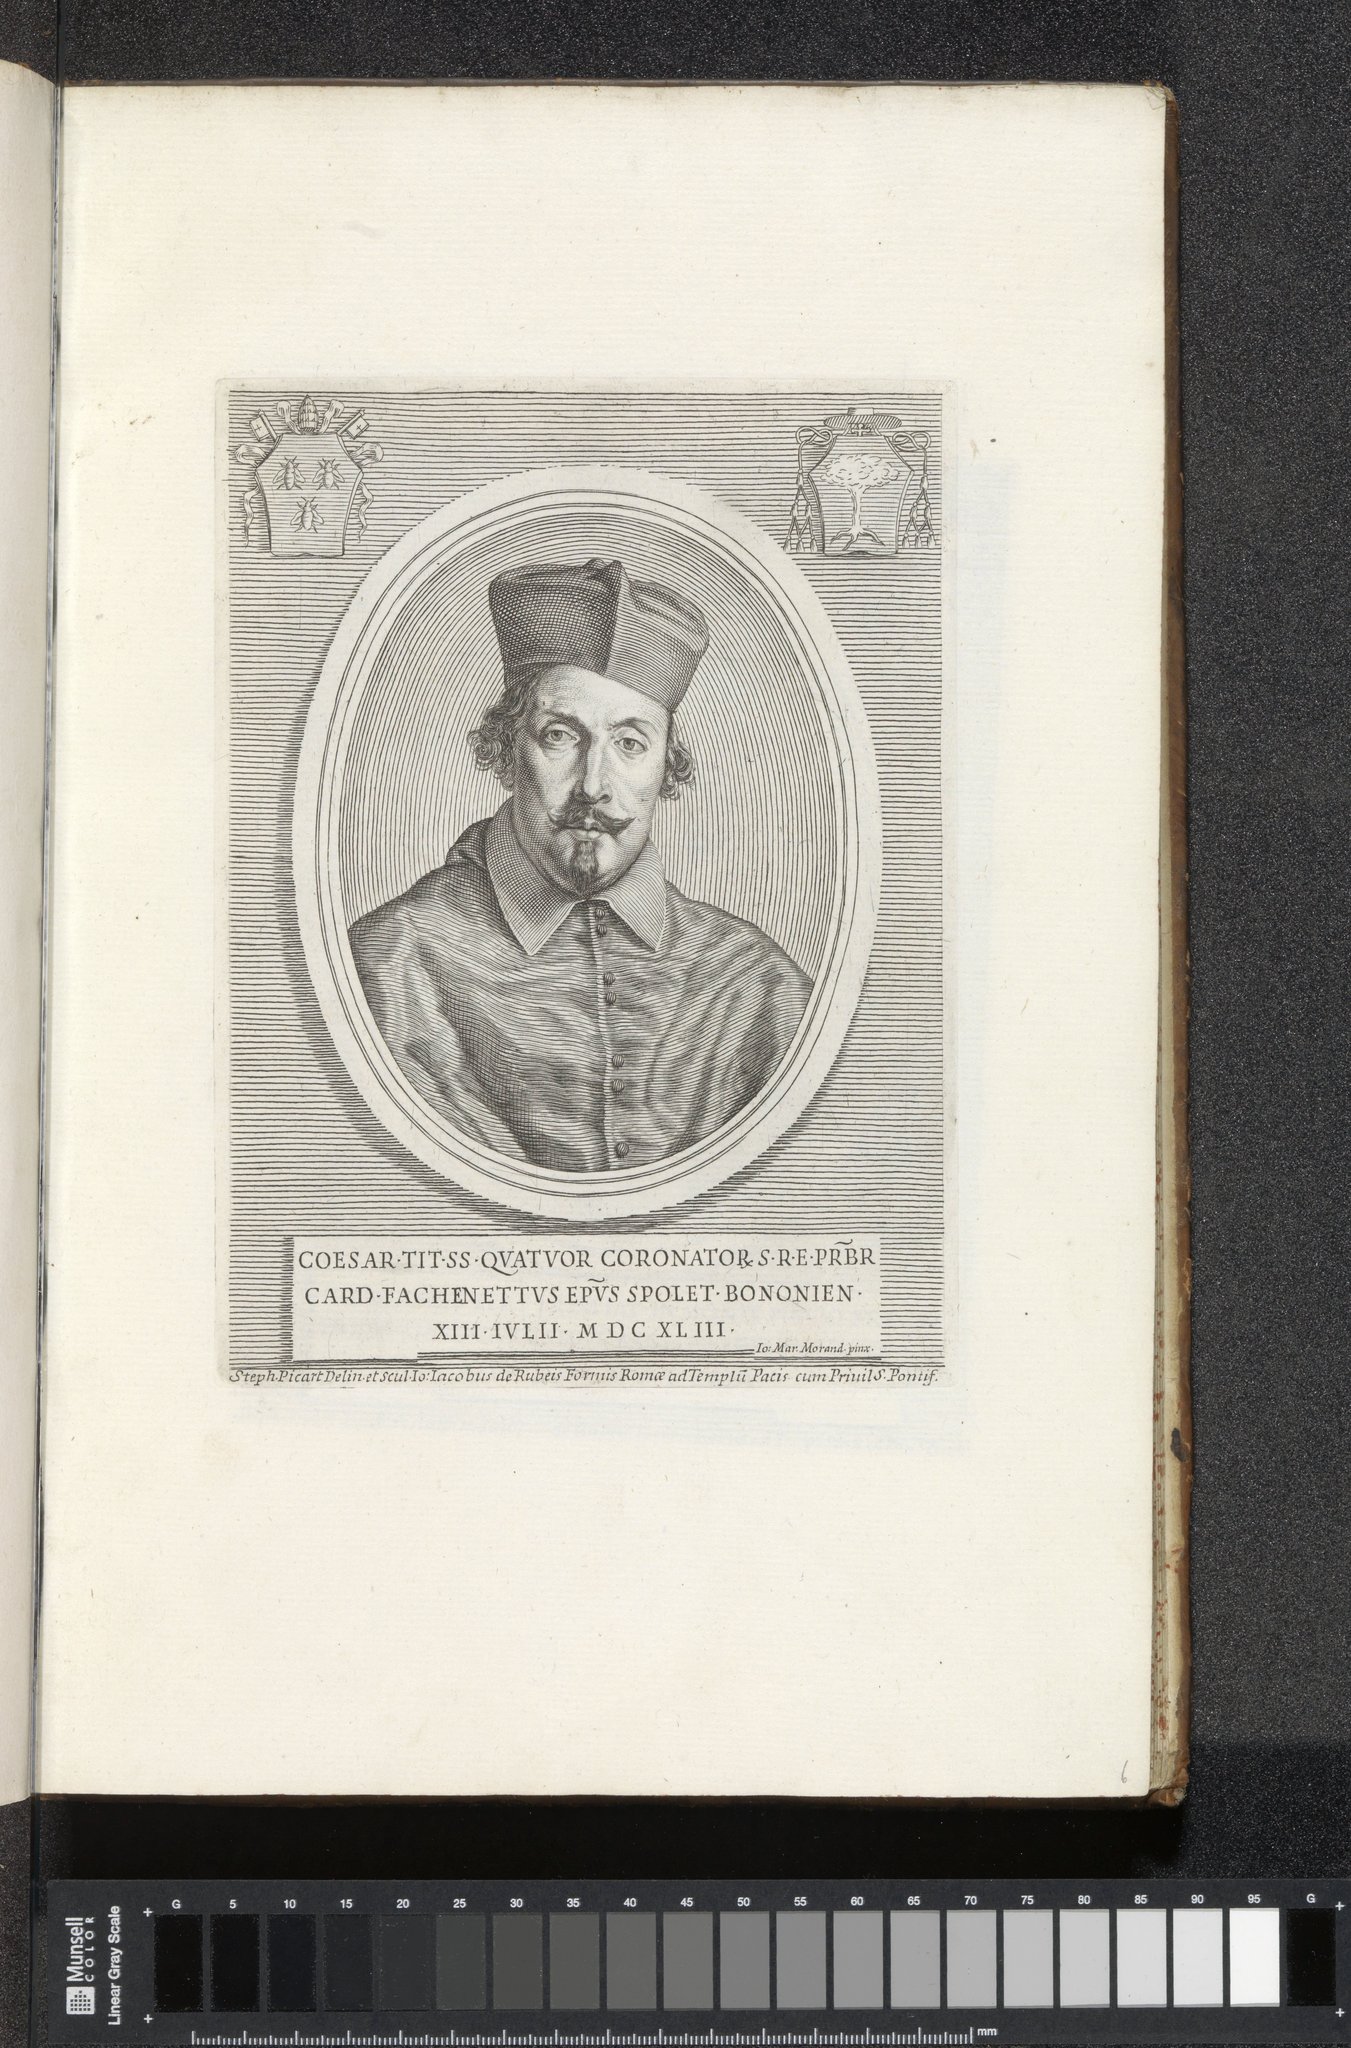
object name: album leaf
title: Effigies Nomina et Cognomina S.D.N. Alexandri Papae VII et RR. DD. SRE. Cardd (...).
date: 1658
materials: paper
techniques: engraving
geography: rome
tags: cardinal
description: Portret van kardinaal Cesare Facchinetti. Linksboven het wapen van paus Urbanus VIII en rechtsboven het wapen van kardinaal Facchinetti. Onderaan een onderschrift in het Latijn. De prent maakt deel uit van een album.